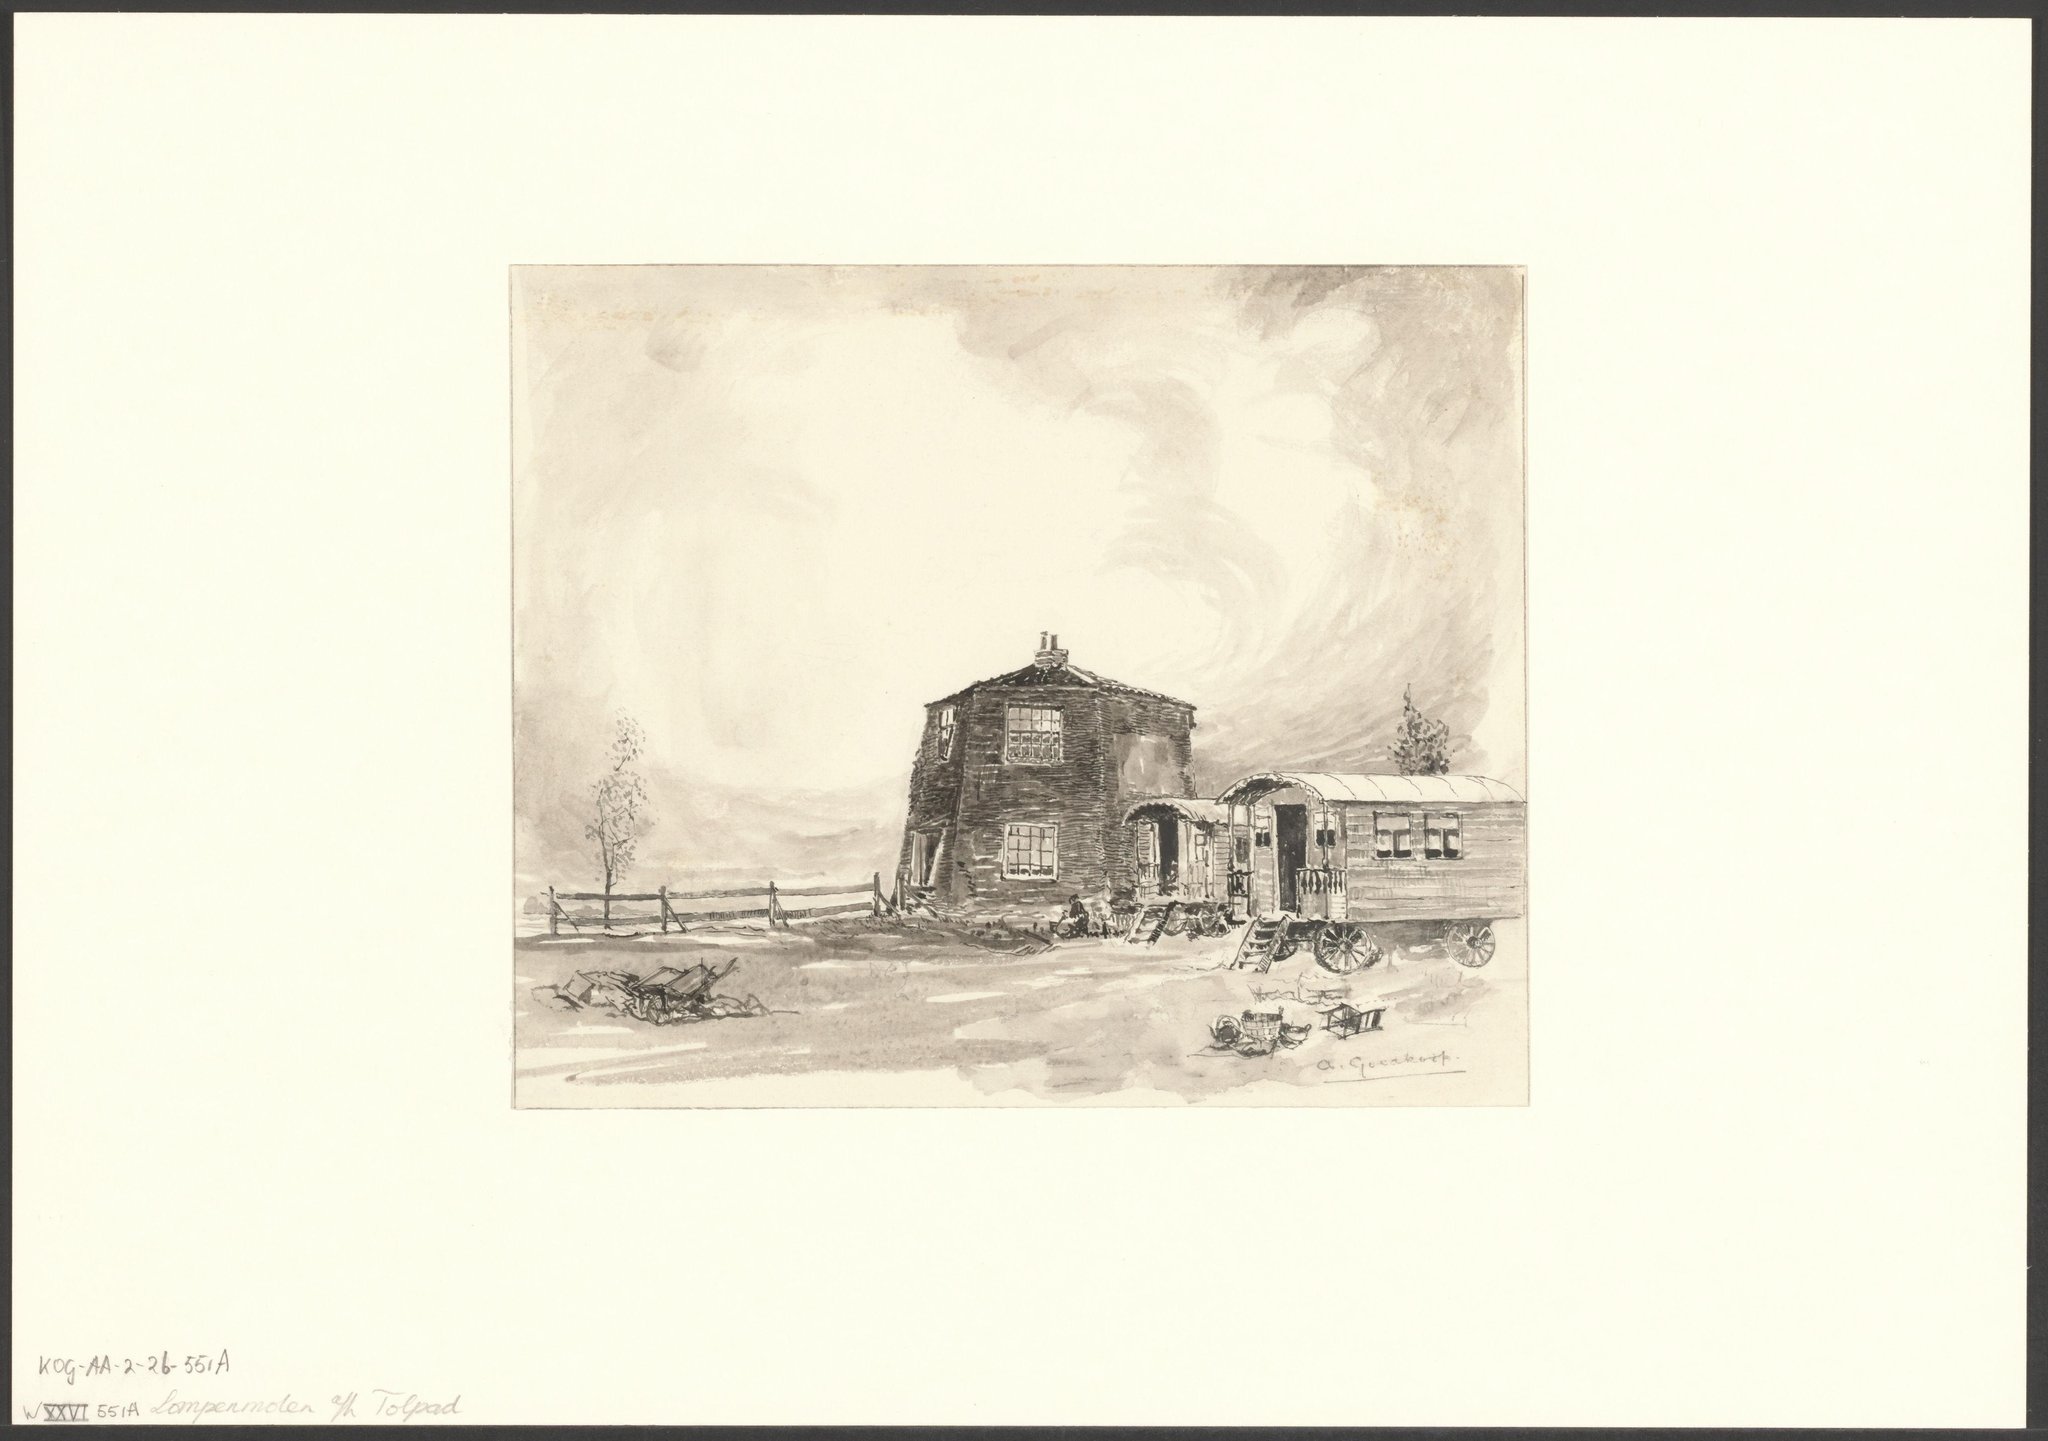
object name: drawing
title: Gezicht op molen De Duif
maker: goedkoop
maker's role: draughtsman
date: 1896-1950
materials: ink, paper, pencil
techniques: brush, pen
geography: amsterdam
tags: city-view in general; 'veduta', windmill in landscape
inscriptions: inscription: ‘oude lompen molen. / aanhet tolpad.’, signature: ‘A. Goedkoop’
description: Tekening binnen de Atlas Van Eck ingedeeld op wijknummer 26.